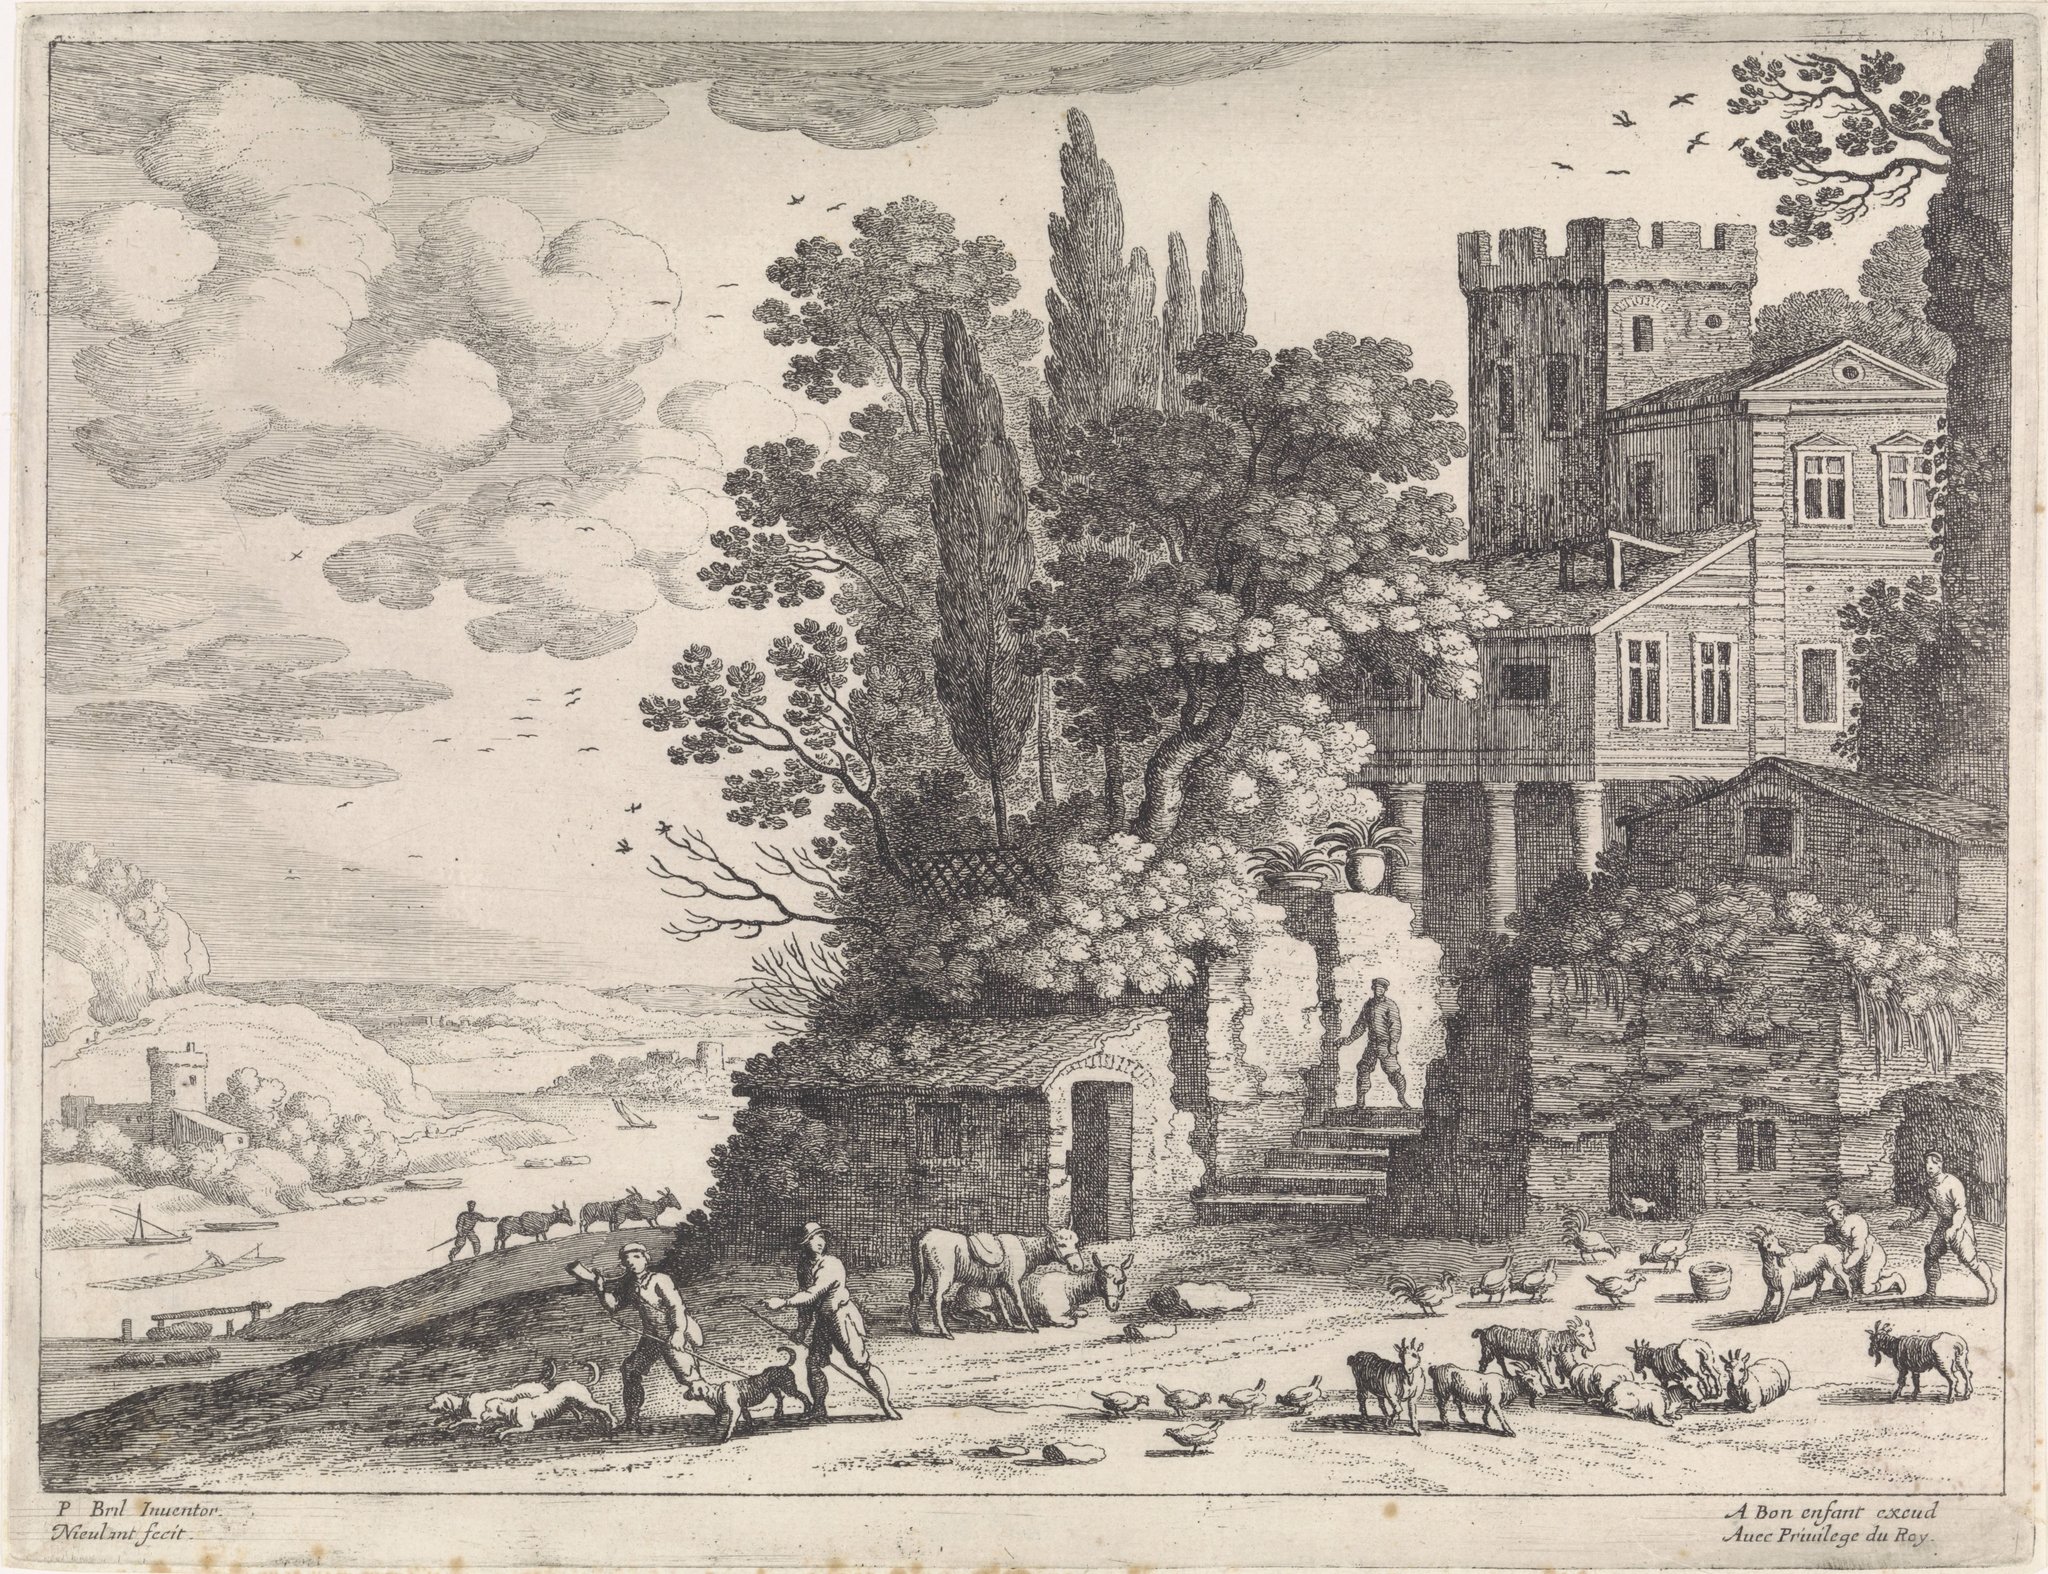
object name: print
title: Landschap met een huis, figuren en vee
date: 1594-1635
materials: paper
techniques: engraving, etching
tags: cattle, landscapes in the temperate zone, hunting horn, villa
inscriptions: collector's mark: Lugt 240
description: Een Italiaans landschap met een huis met toren. Op de voorgrond geiten, kippen, ezels en twee mannen met jachthoorn en jachthonden. Links zicht op een rivier.